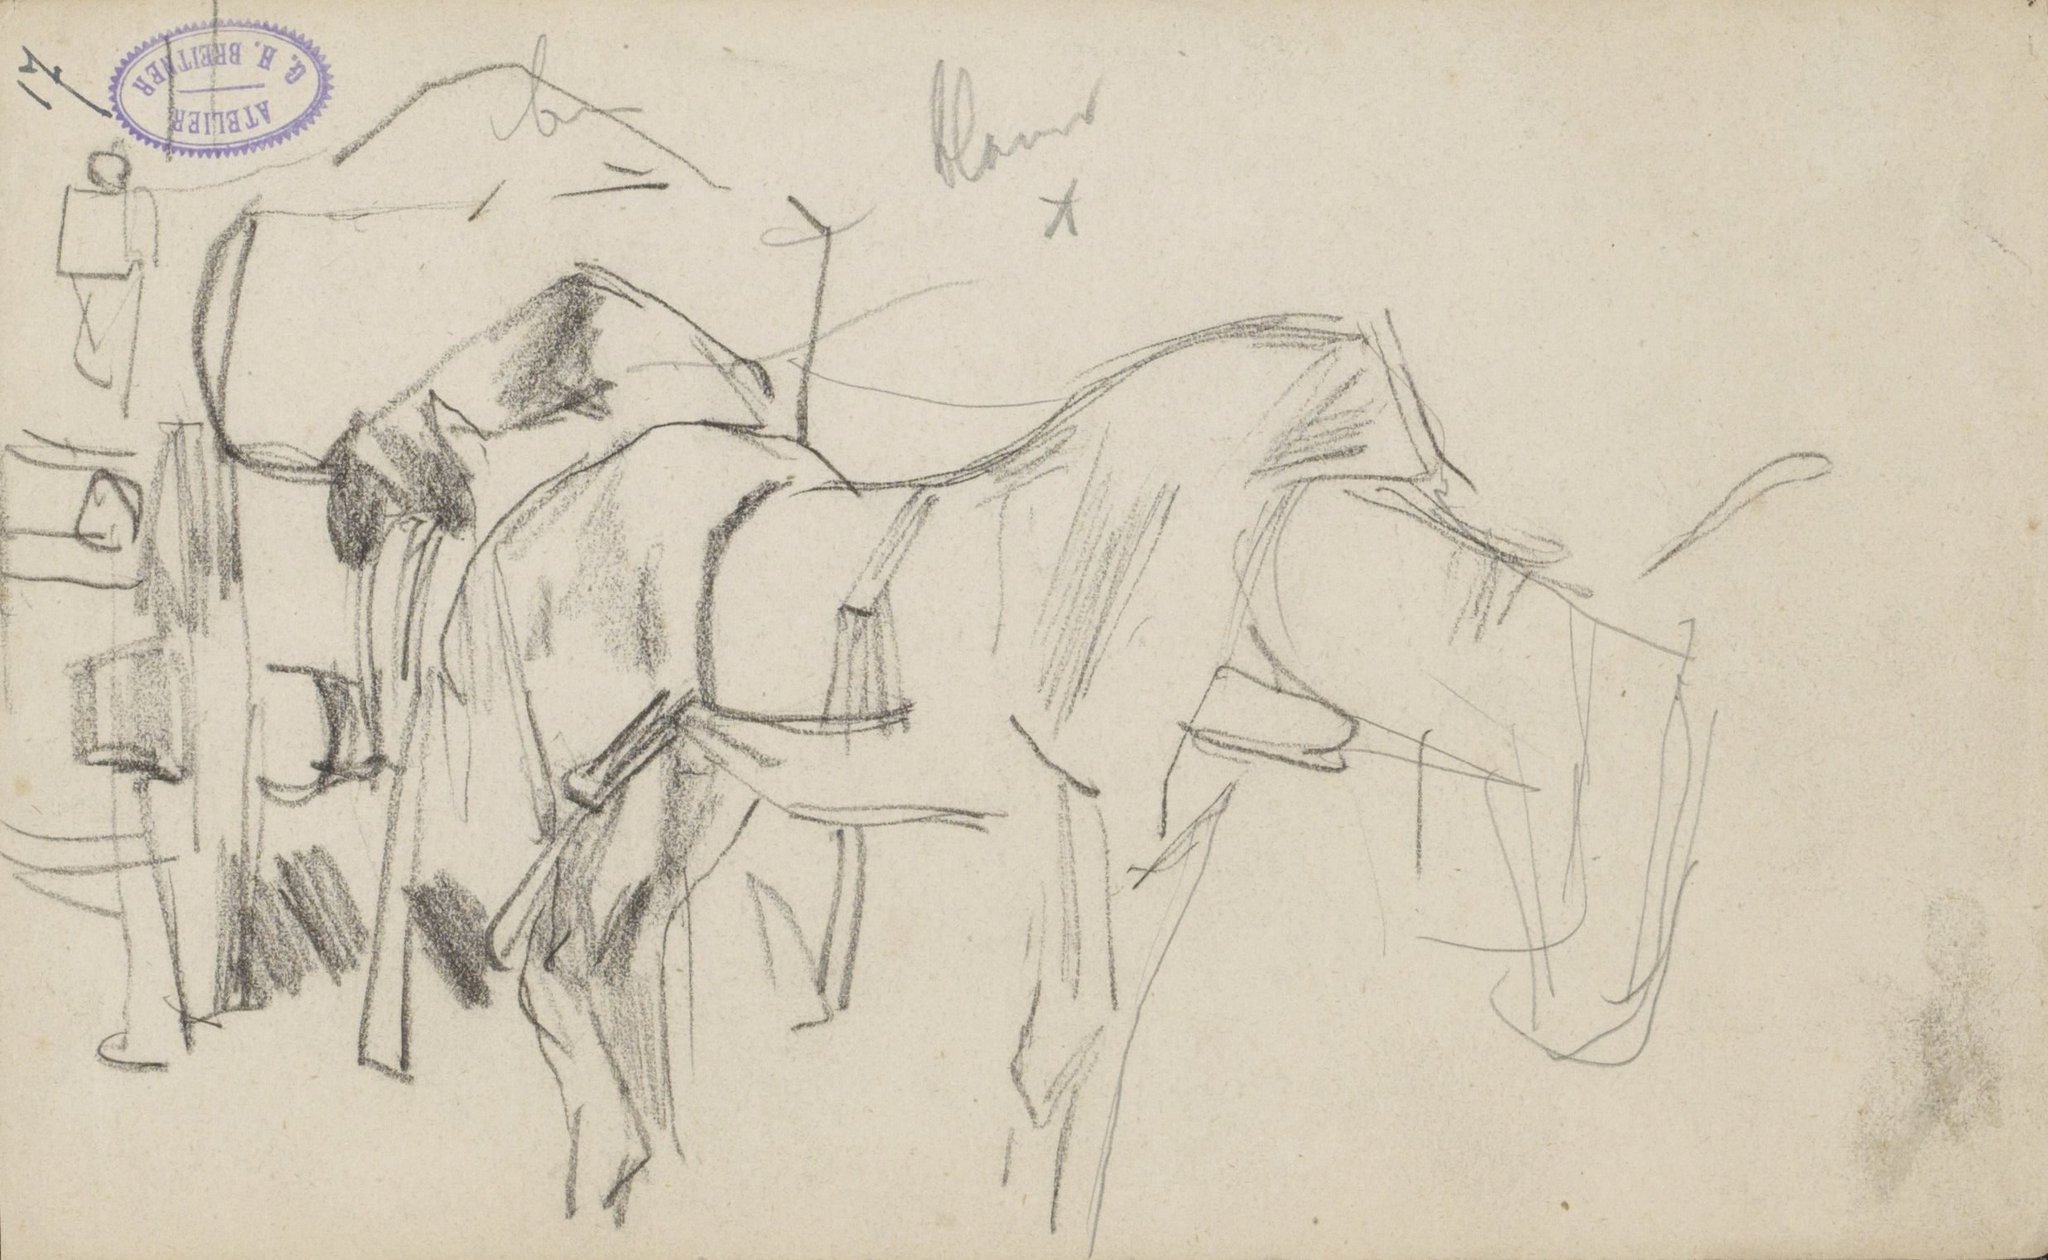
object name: drawing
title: Paarden voor een wagen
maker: george hendrik breitner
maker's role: draughtsman, painter, print maker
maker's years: 1857-1923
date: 1888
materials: chalk, paper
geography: amsterdam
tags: four-wheeled, animal-drawn vehicle, e.g.: cab, carriage, coach, horse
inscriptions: workshop stamp: Lugt 291d, :, collector's mark: Lugt 2228